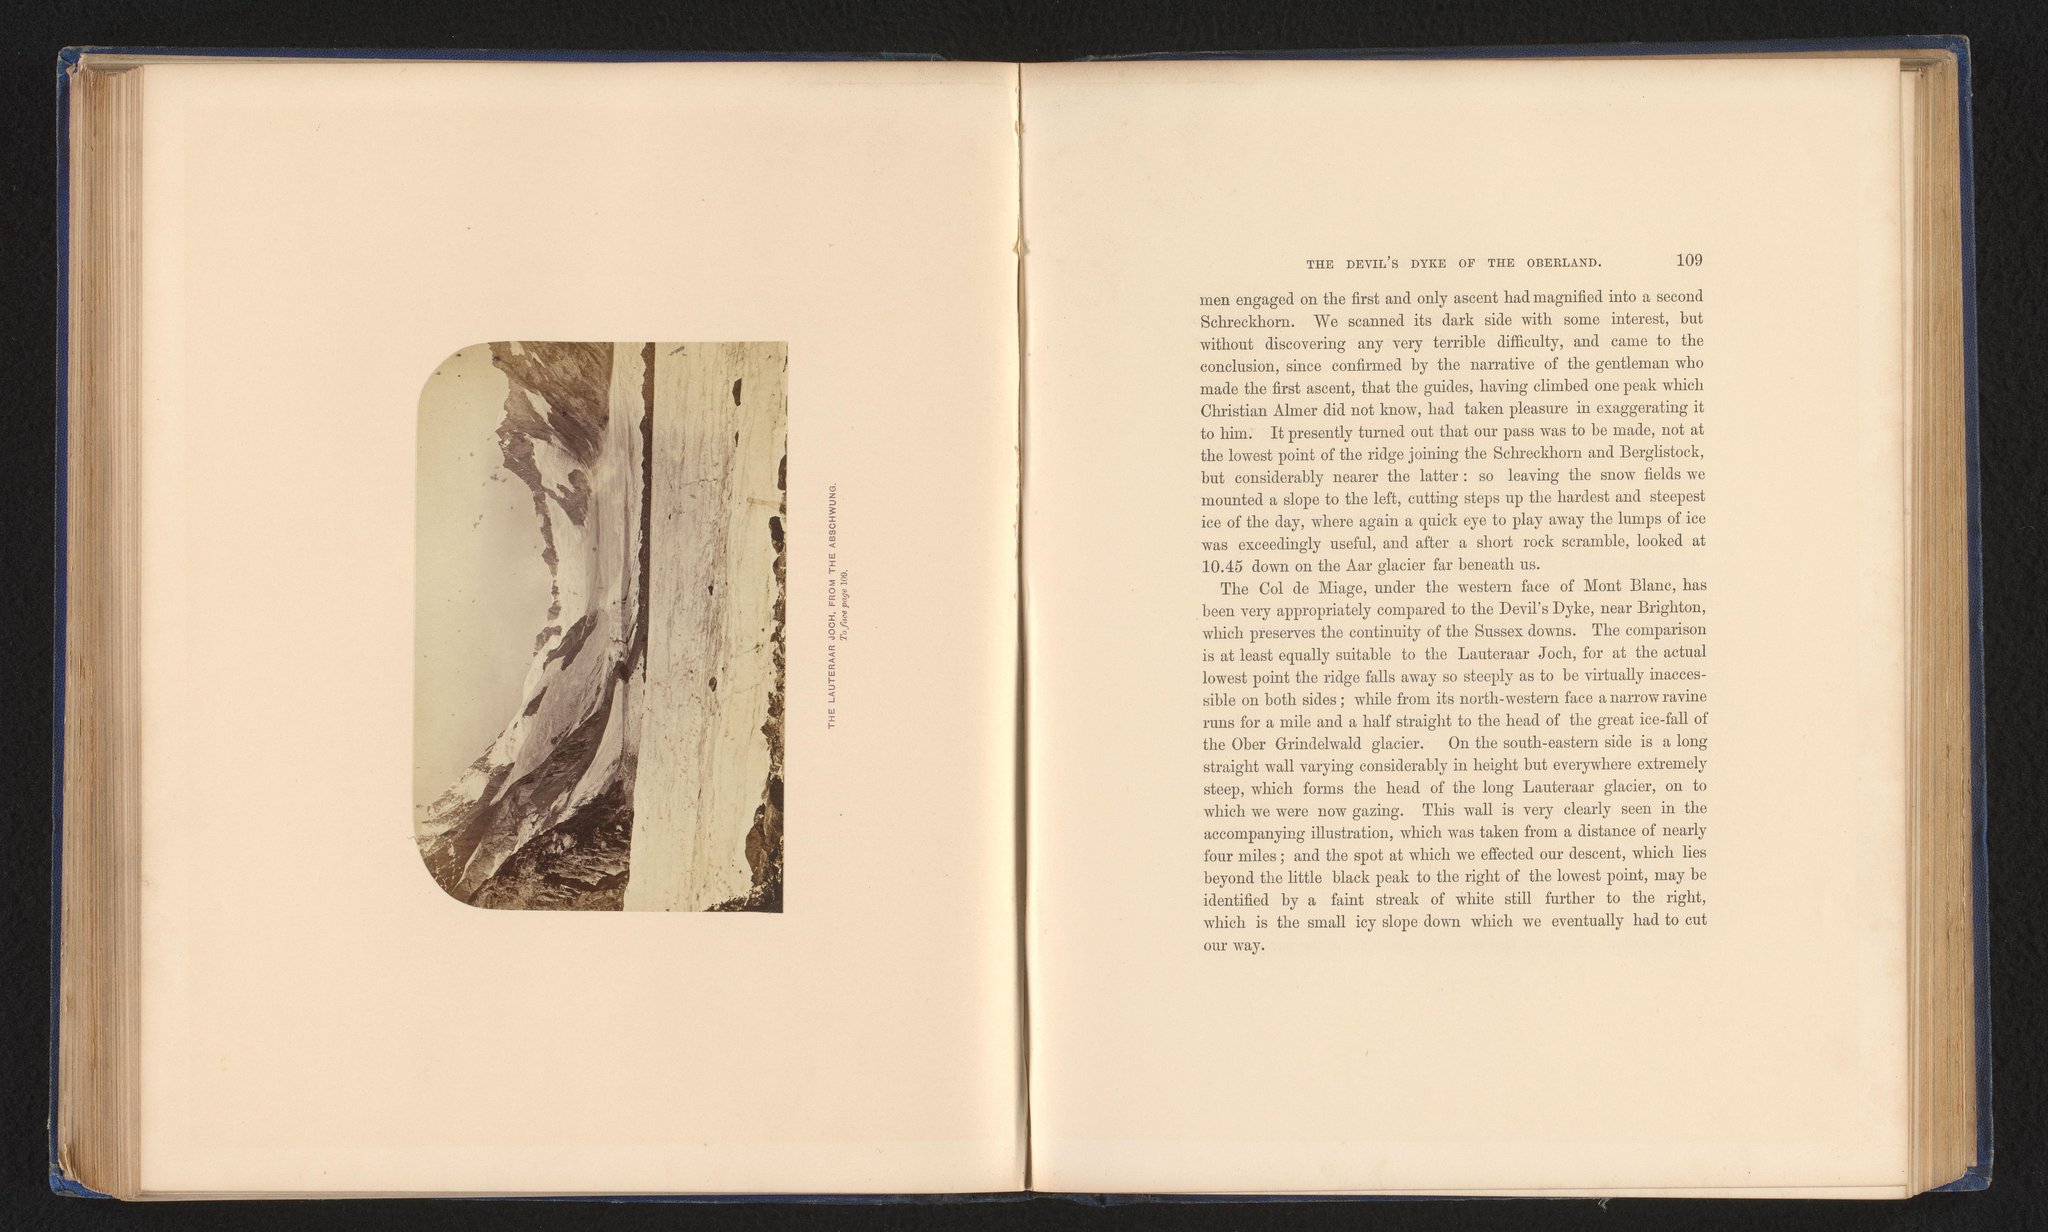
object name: photograph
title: Gezicht op een dal bij de Lauteraarhorn in de Berner Alpen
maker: ernest edwards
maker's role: fotograaf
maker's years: 1837-1903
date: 1861-1866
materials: paper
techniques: albumen print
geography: berner alpen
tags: dale, valley, mountains